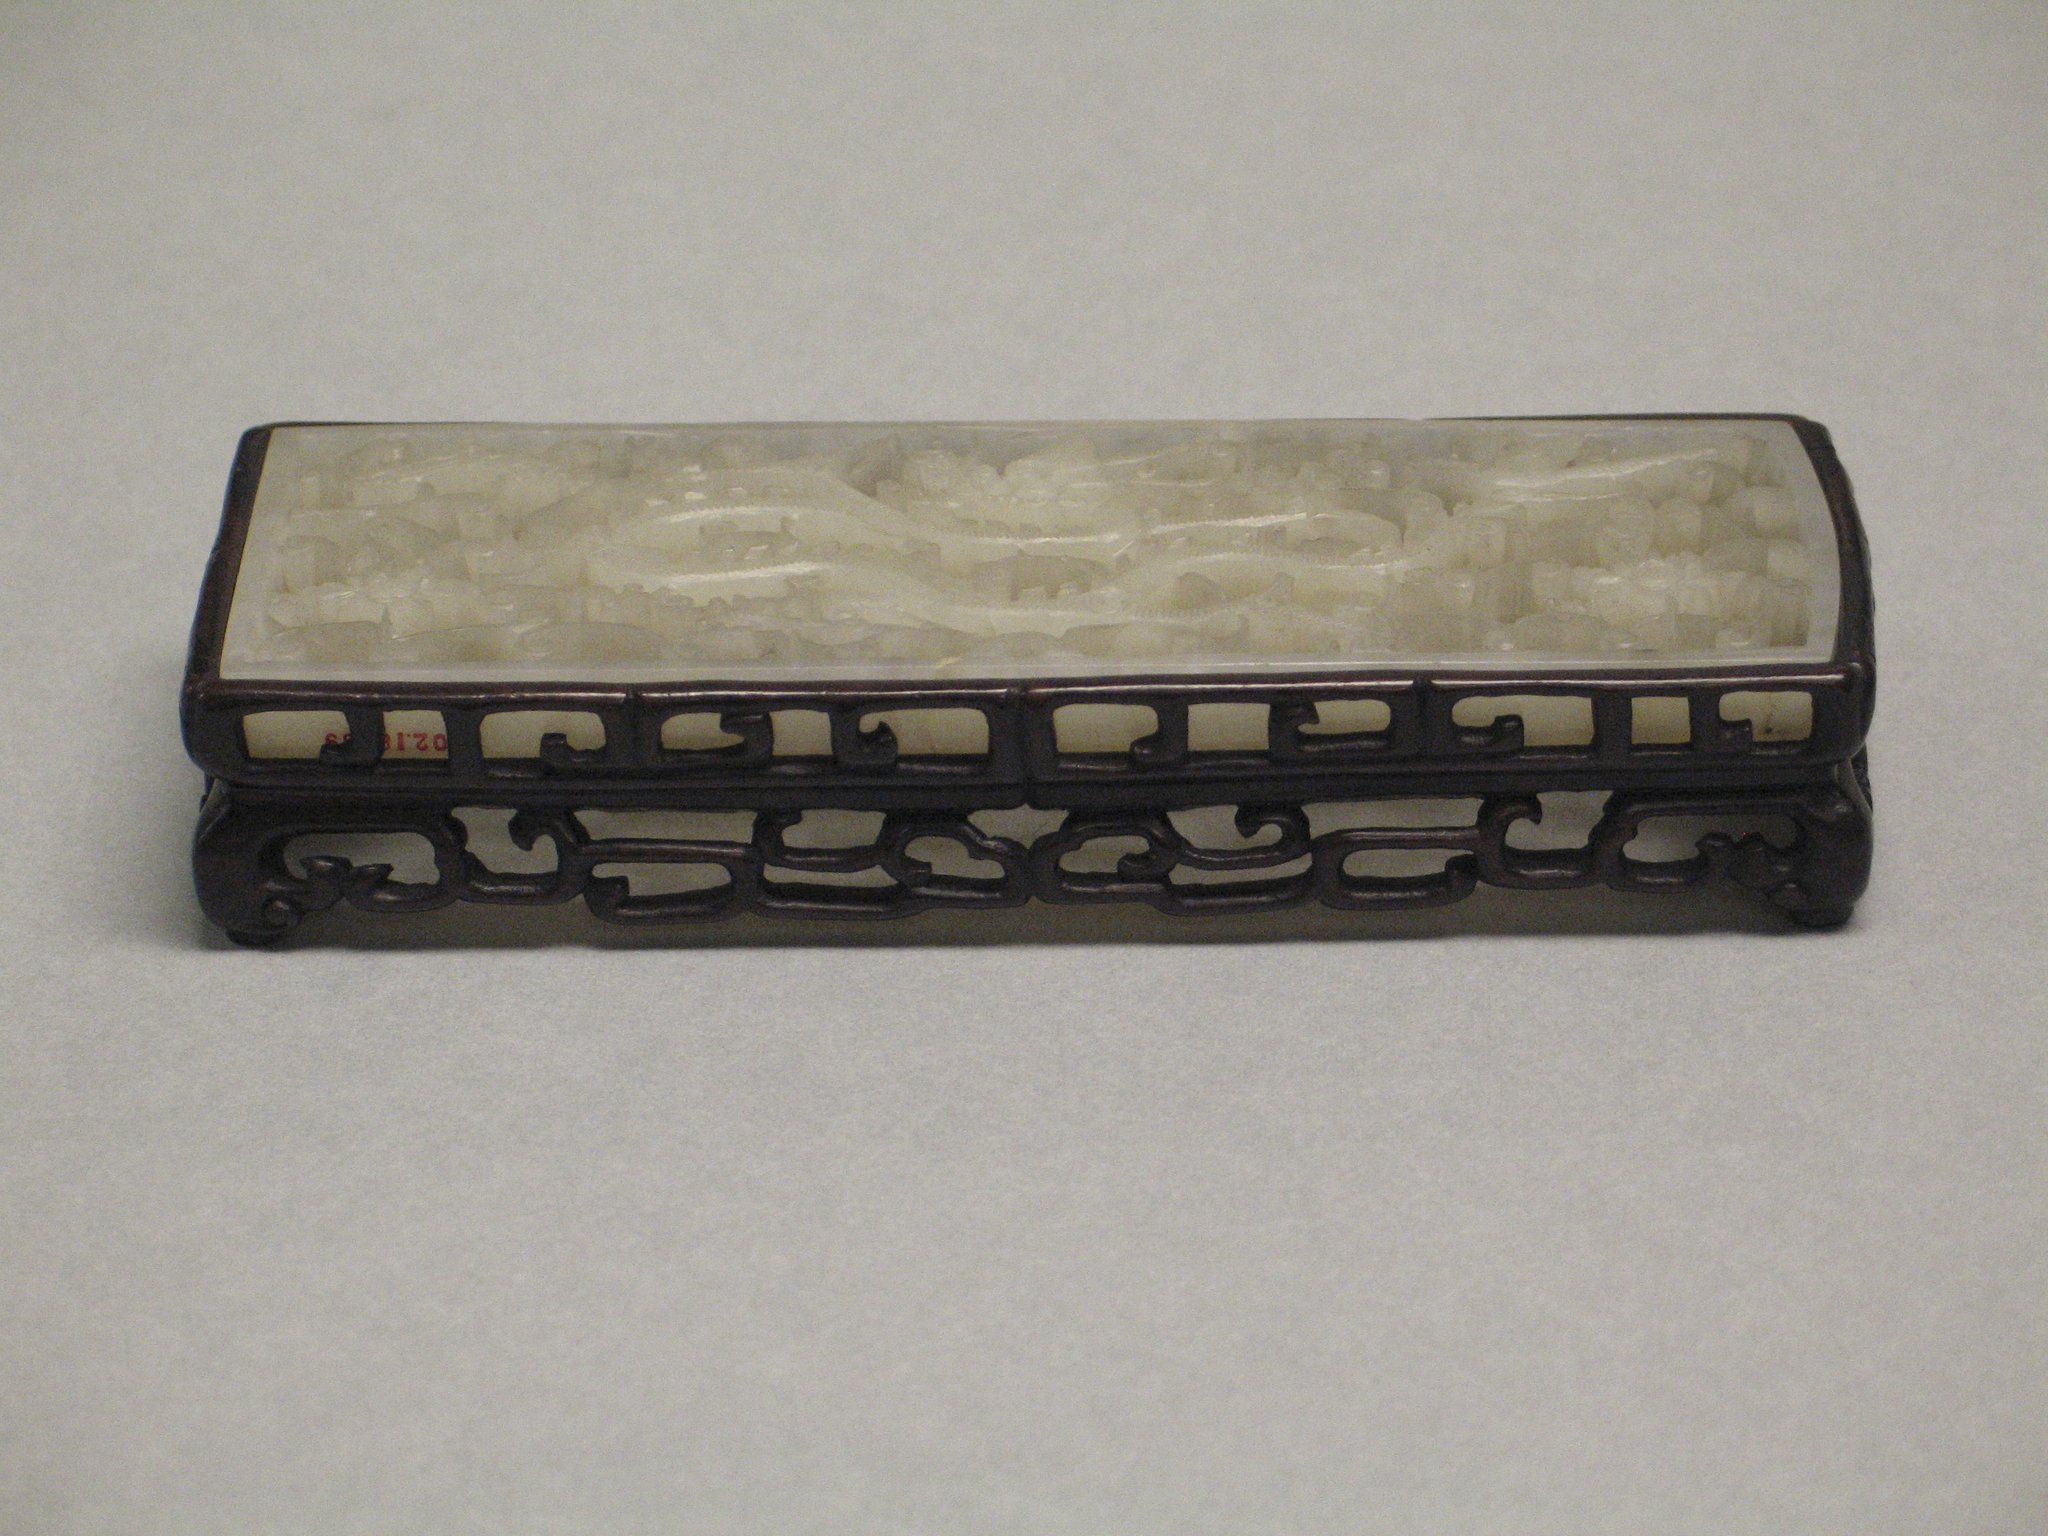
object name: belt plaque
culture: chinese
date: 1501-1600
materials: jade